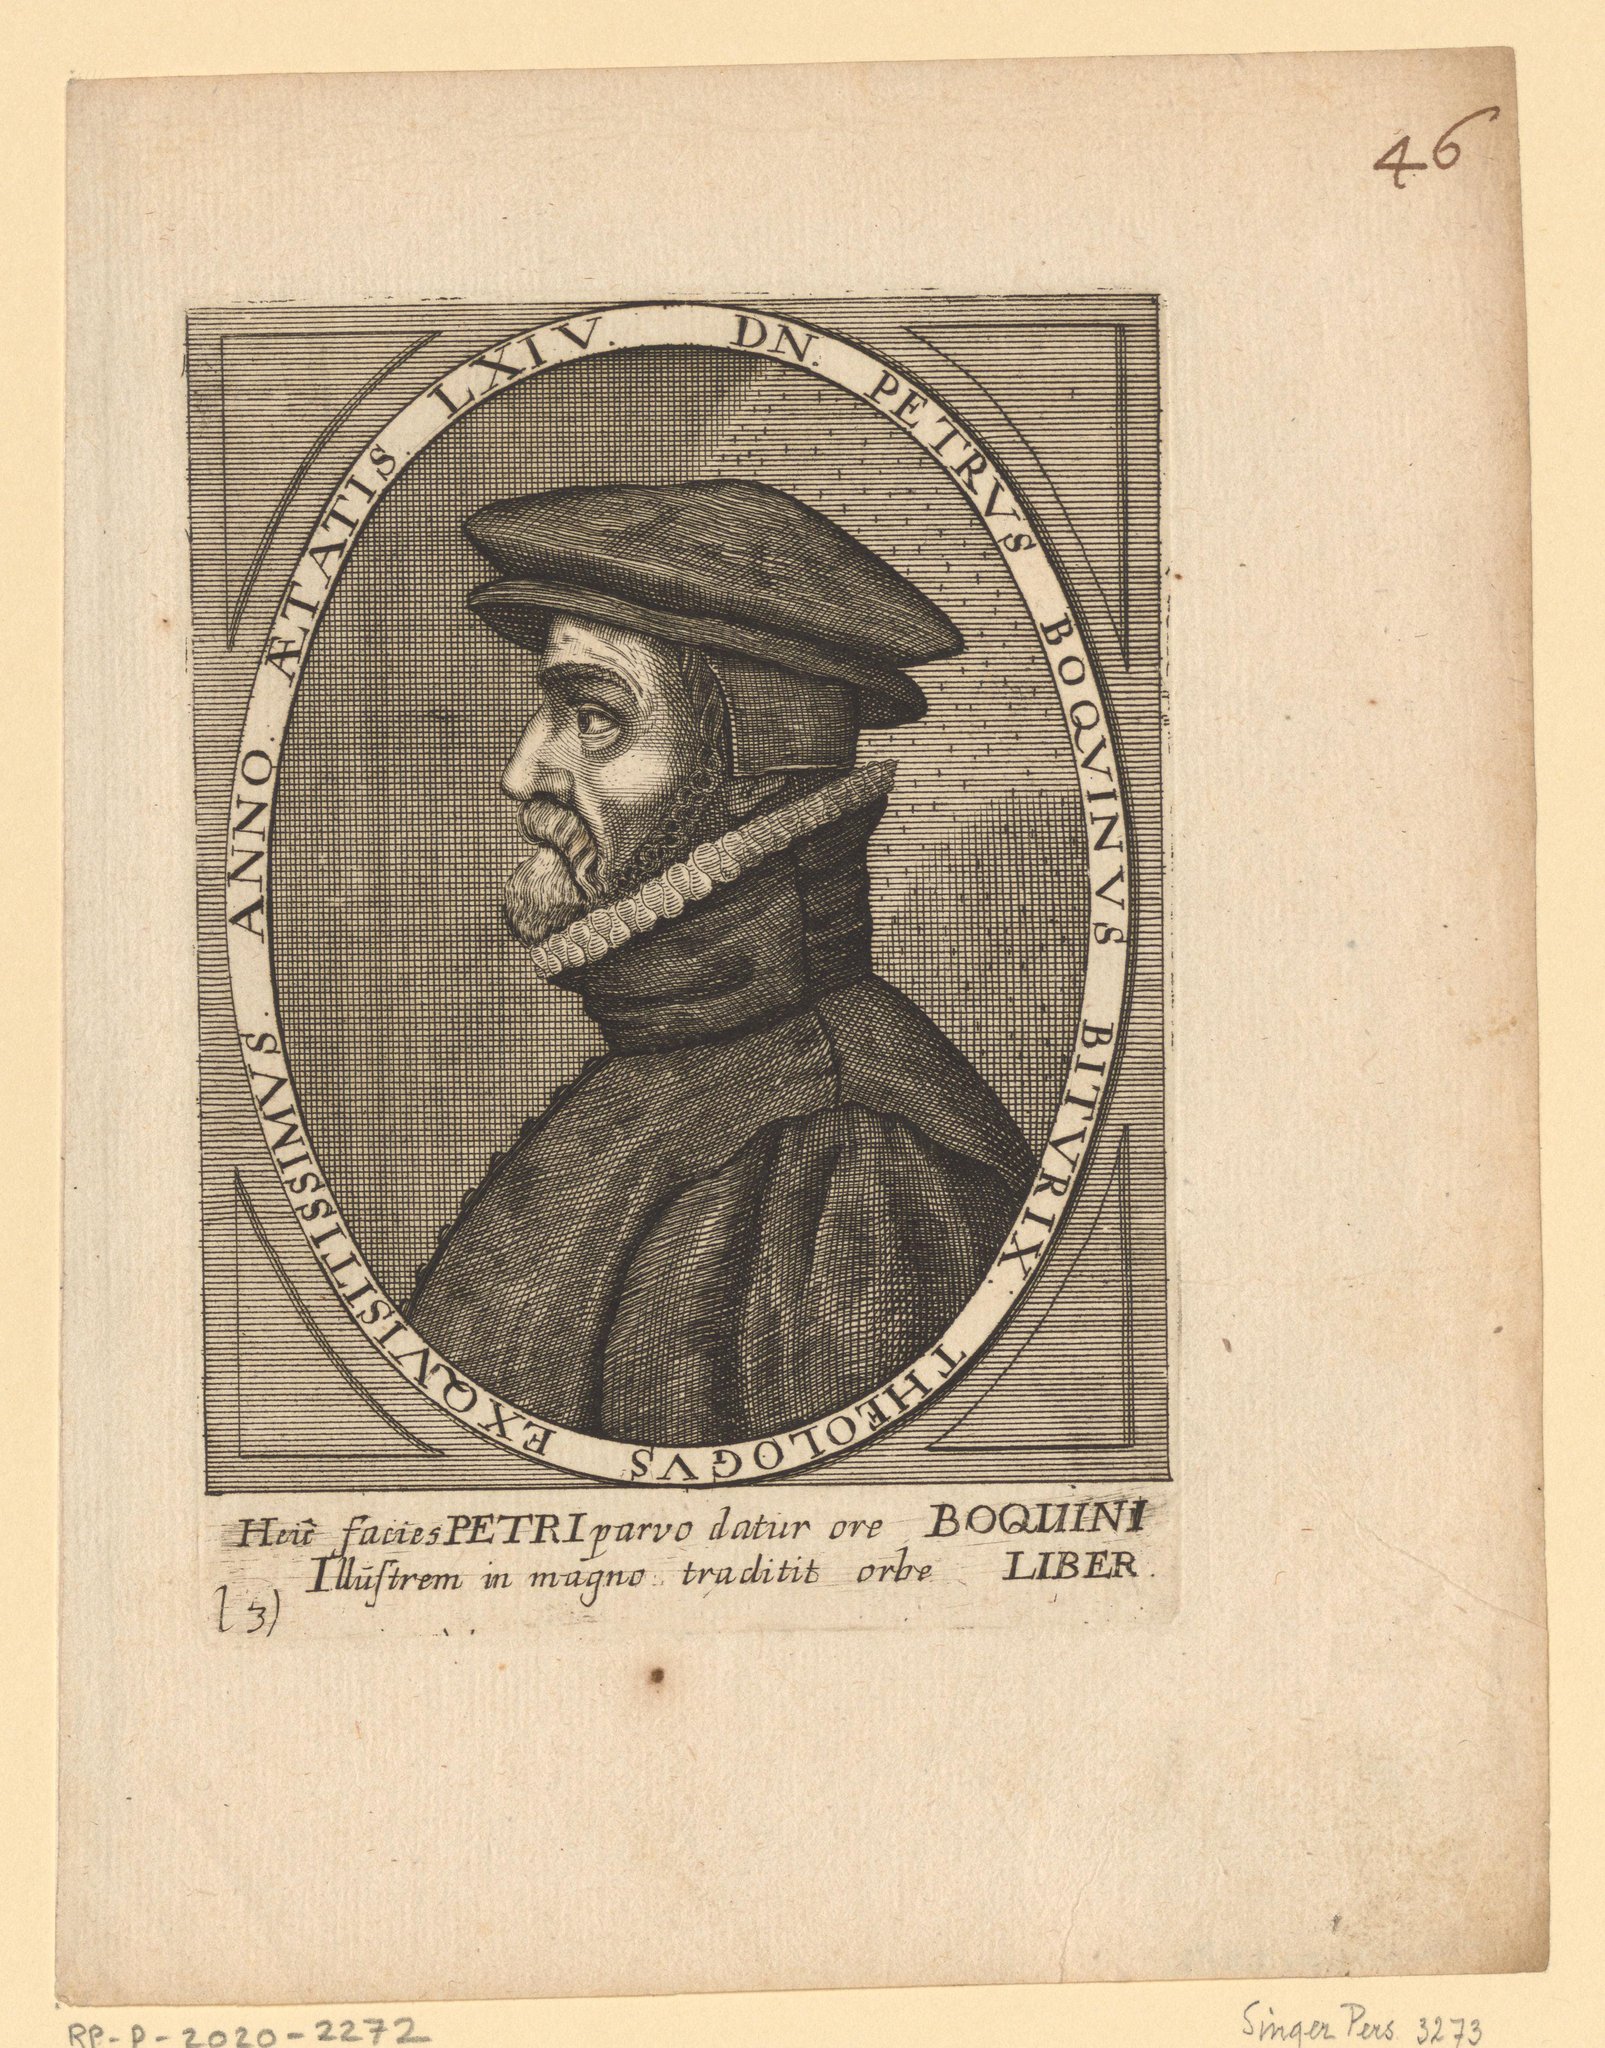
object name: print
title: Portret van Pierre Boquin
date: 1650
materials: paper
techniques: engraving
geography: frankfurt am main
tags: theologian, historical persons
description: Prent uit: Bibliotheca chalcographica. Frankfurt am Main: Johannes Ammon, 1650, dl. 6.